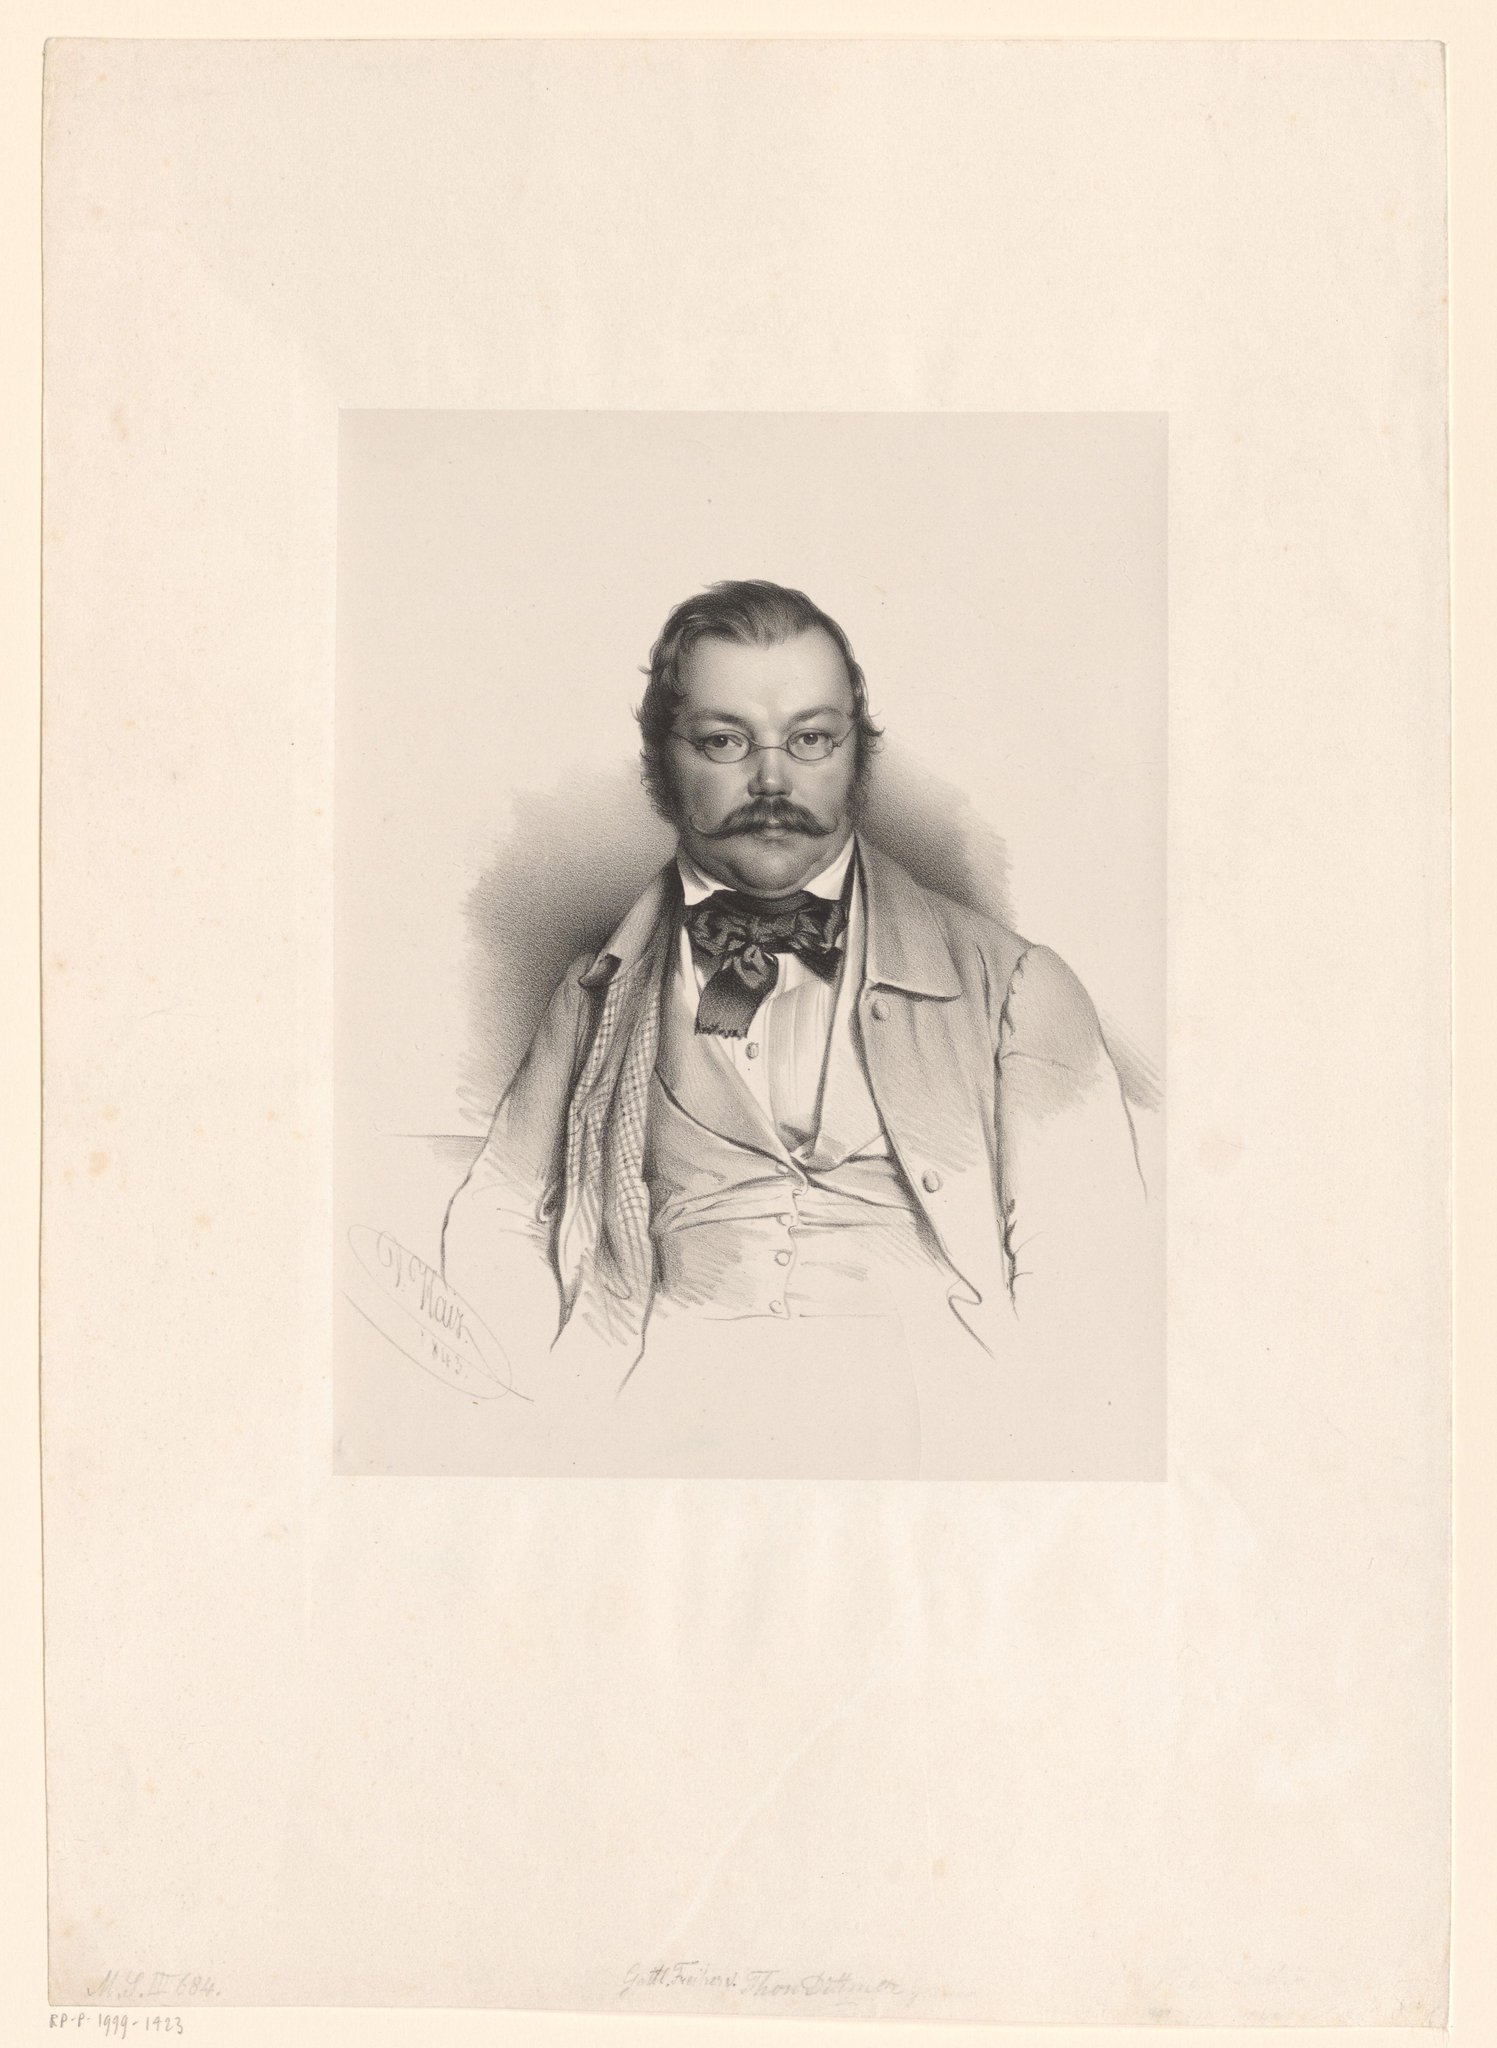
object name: print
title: Portret Gottlieb Freiherr von Thon-Dittmer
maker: dominik haiz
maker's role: painter, print maker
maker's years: 1810-1847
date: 1843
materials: paper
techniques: lithograph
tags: politician, eyeglasses, spectacles, moustache, adult man, historical persons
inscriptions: collector's mark: Lugt 2760, stamp, collector's mark: Lugt 2228, collector's mark: Lugt 4100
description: Gottlieb Freiherr von Thon-Dittmer (1802-1853). Portret ten halve lijve, van voren gezien, met bril op.